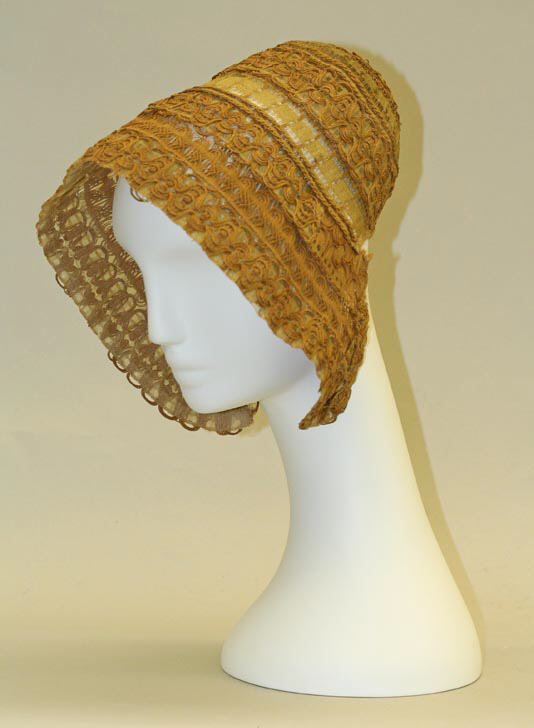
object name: bonnet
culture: american or european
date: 1800-1875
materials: fiber